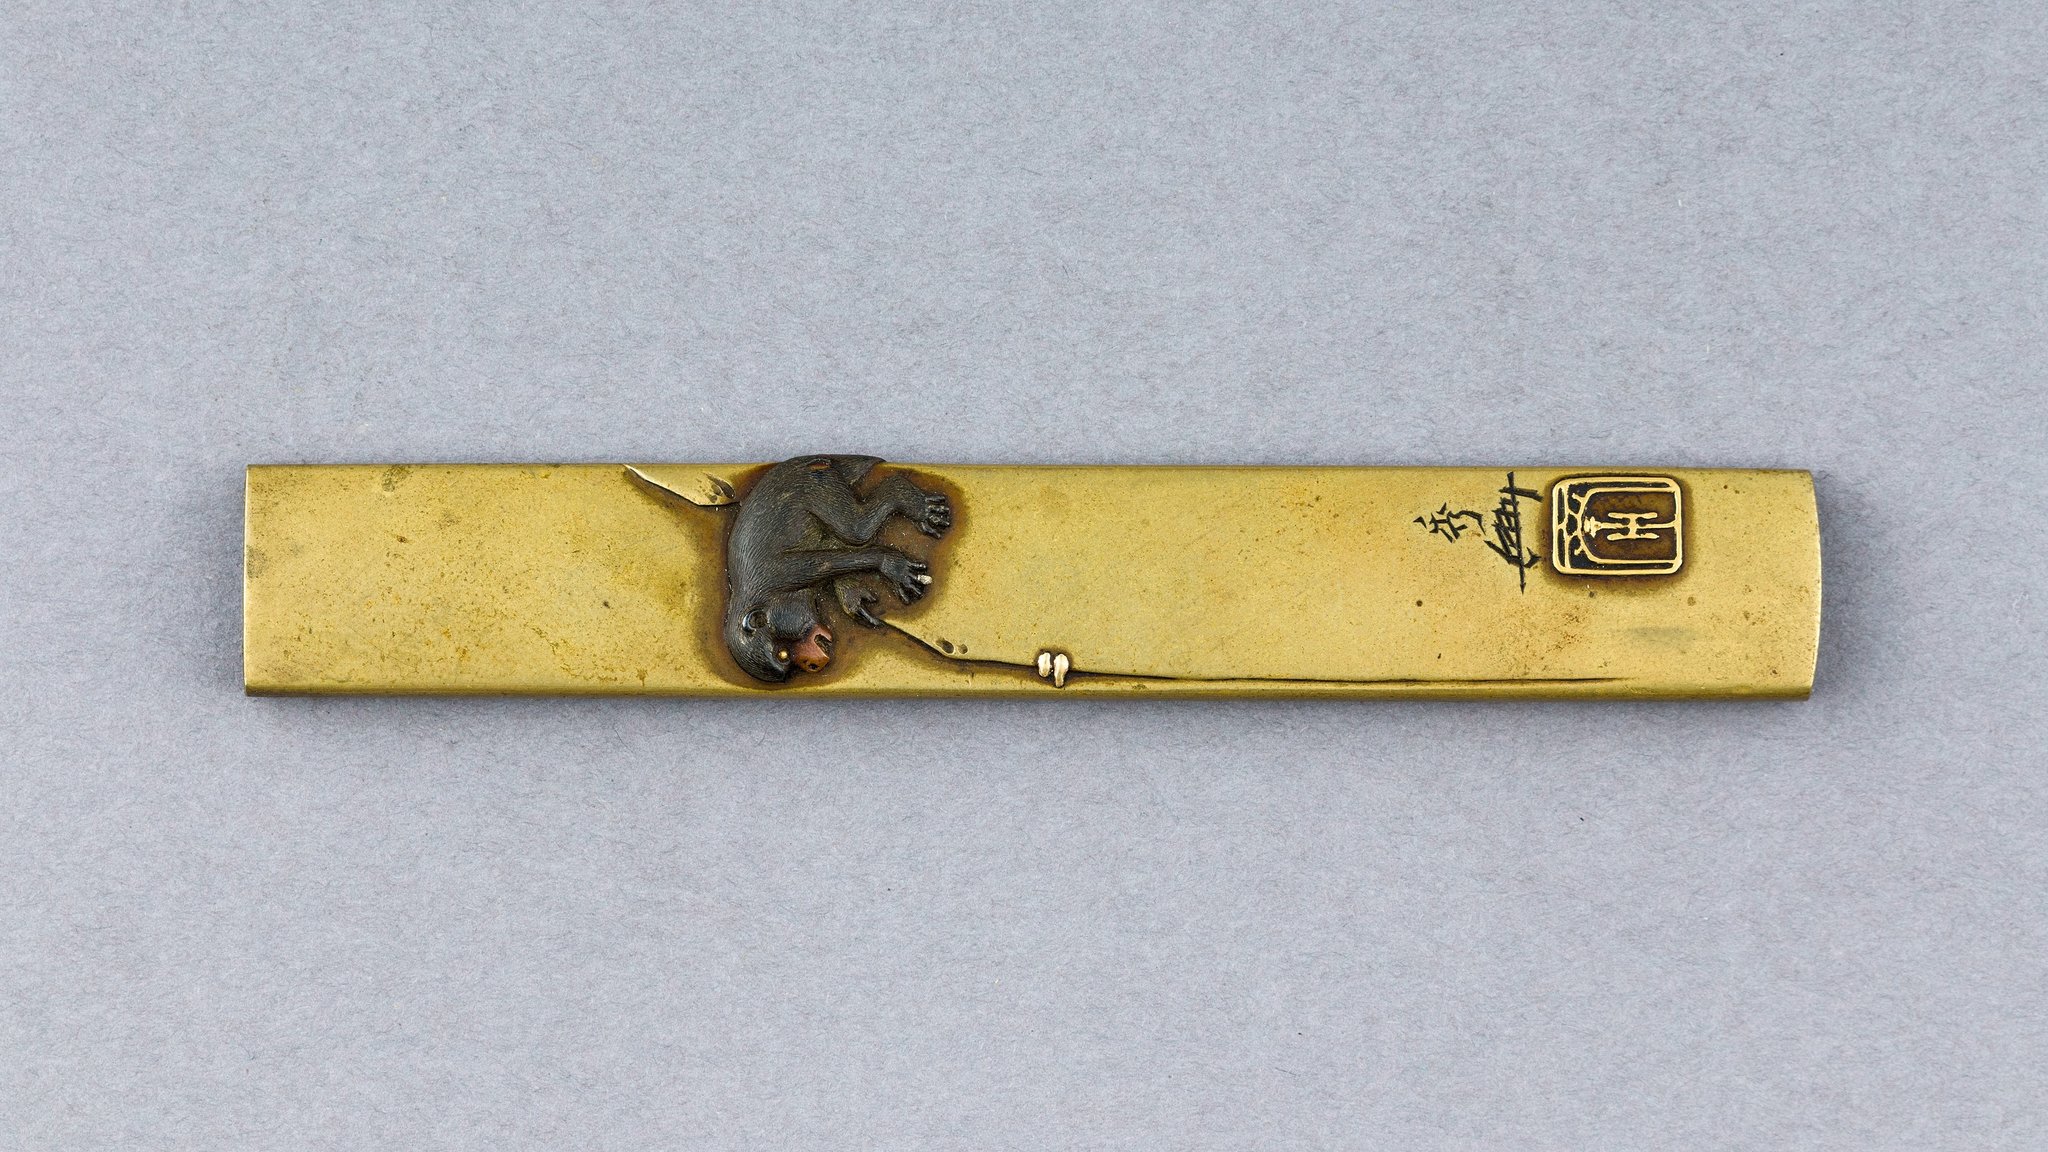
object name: knife handle kozuka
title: Knife Handle (Kozuka)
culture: japanese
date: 1615-1868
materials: copper, copper alloy, silver alloy, gold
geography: japan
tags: monkeys